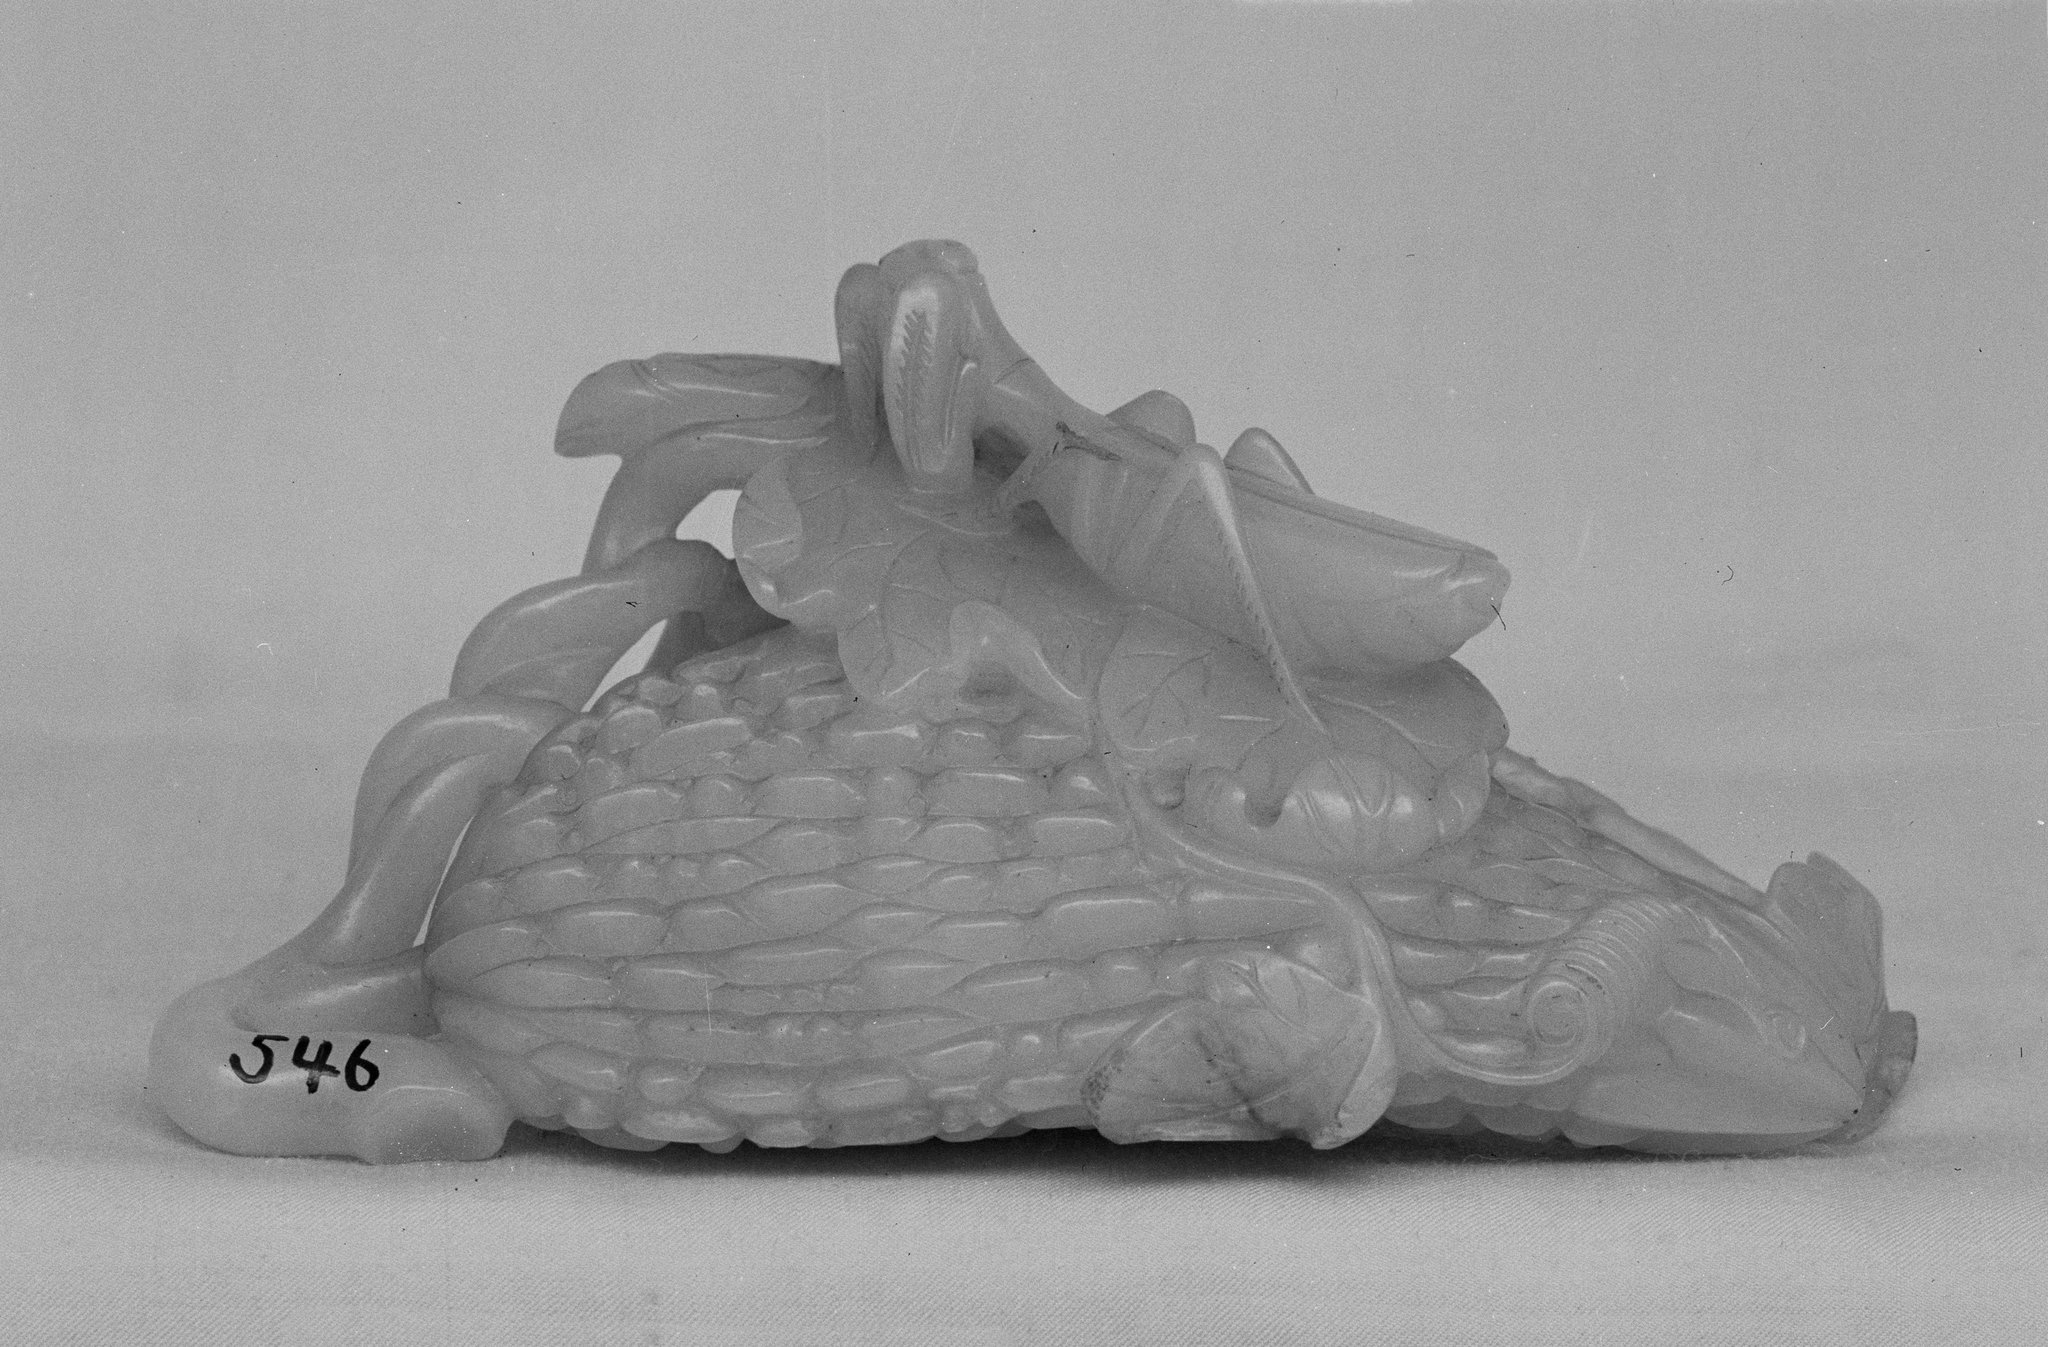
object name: paperweight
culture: chinese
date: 1736-1795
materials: jade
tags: insects